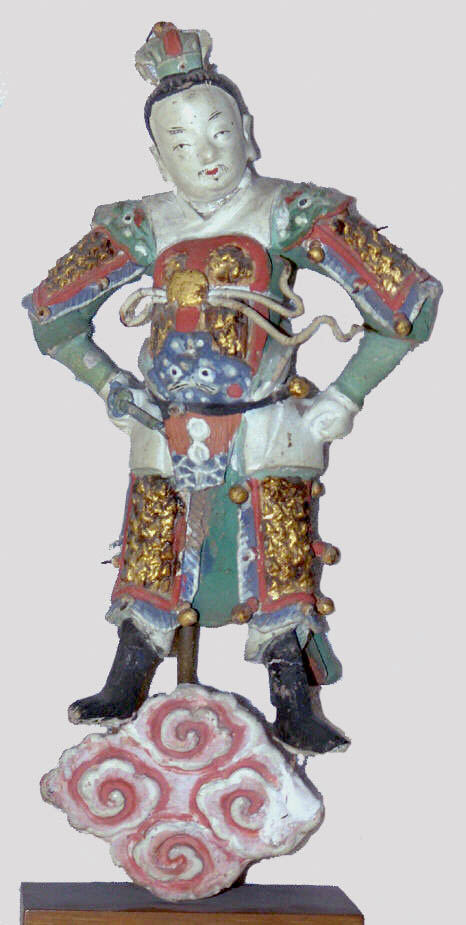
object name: statuette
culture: chinese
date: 1601-1700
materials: mud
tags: men